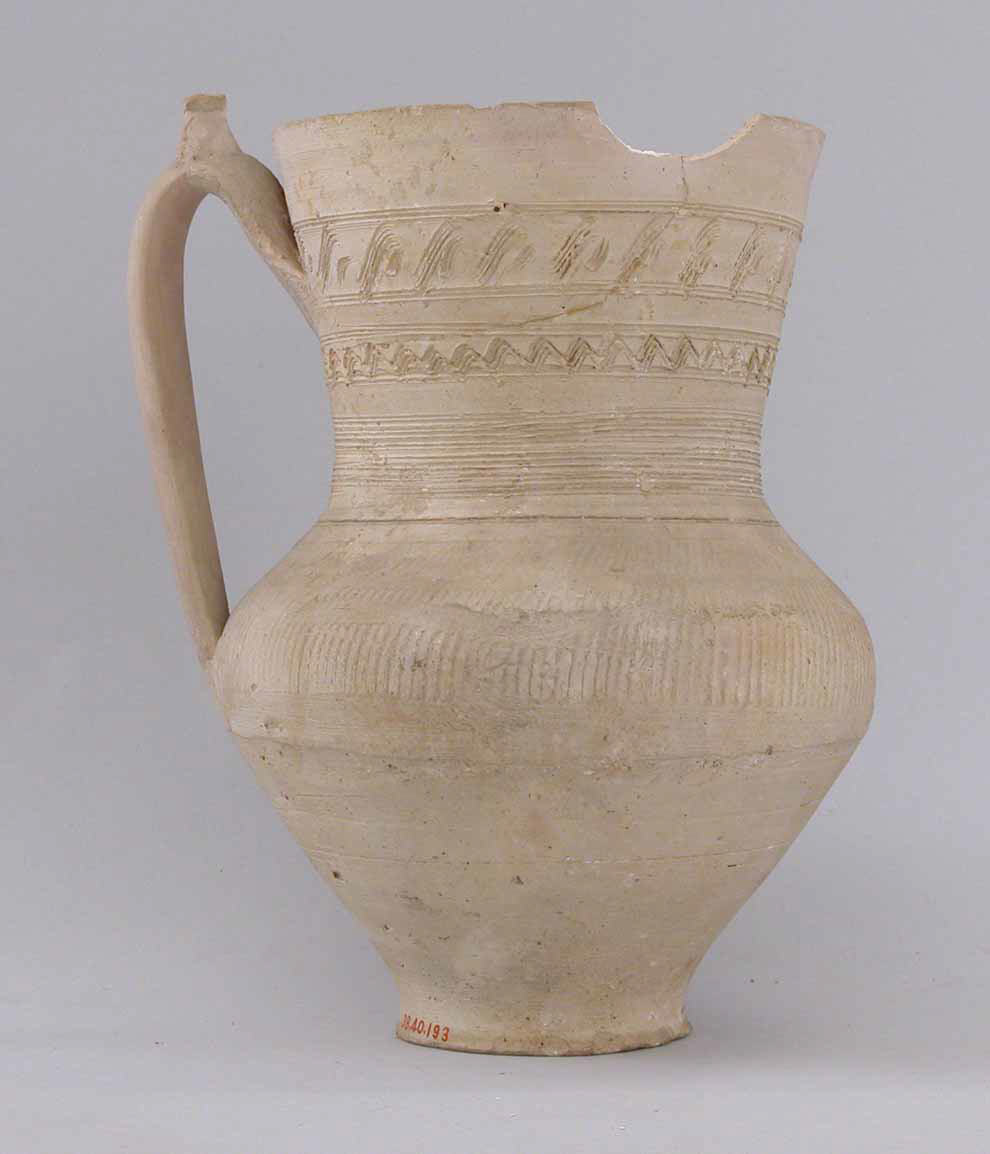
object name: jug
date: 867-933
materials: earthenware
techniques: incising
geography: iran